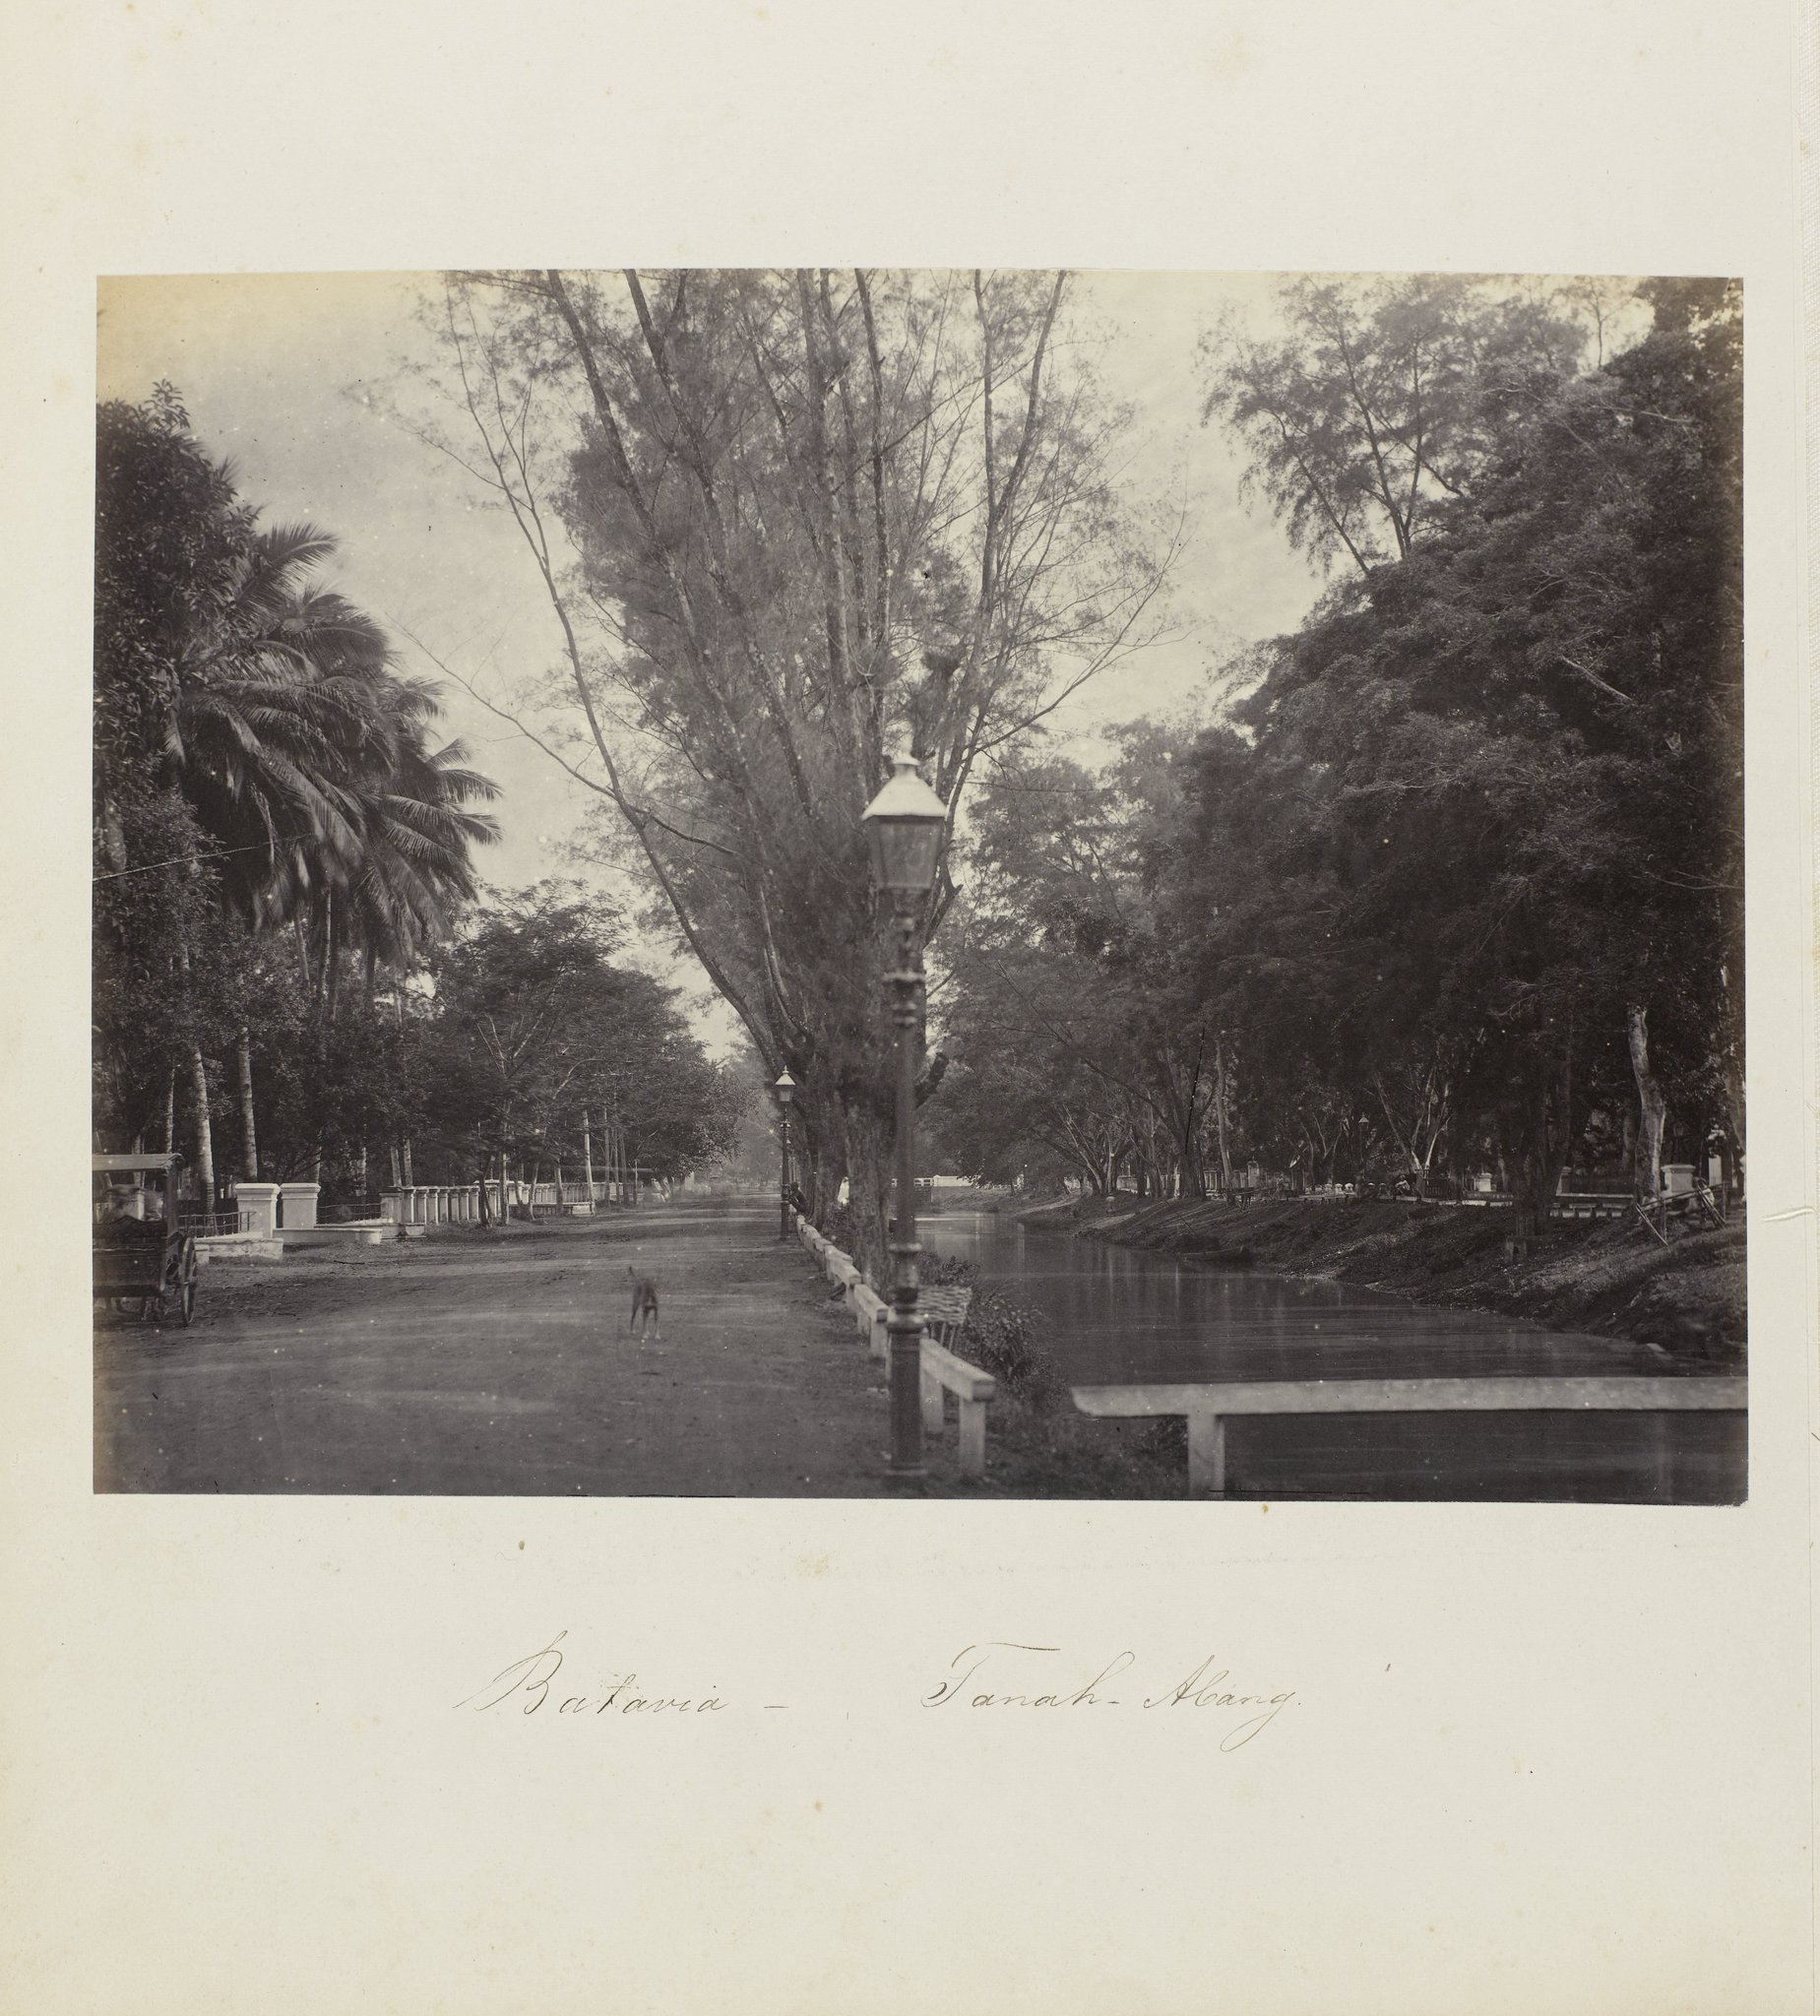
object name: photograph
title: Batavia - Tanah-Abang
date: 1863-1866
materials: photographic support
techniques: albumen print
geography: batavia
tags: street, batavia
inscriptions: inscription: ‘Batavia - Tanah-Abang’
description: Gezicht in de Tanah Abang in Batavia, straat en vaart. Onderdeel van het rode fotoalbum met foto's van Java, uit het bezit van apotheker Specht-Grijp, die in 1865 vanuit Batavia naar Nederland terugkeerde.